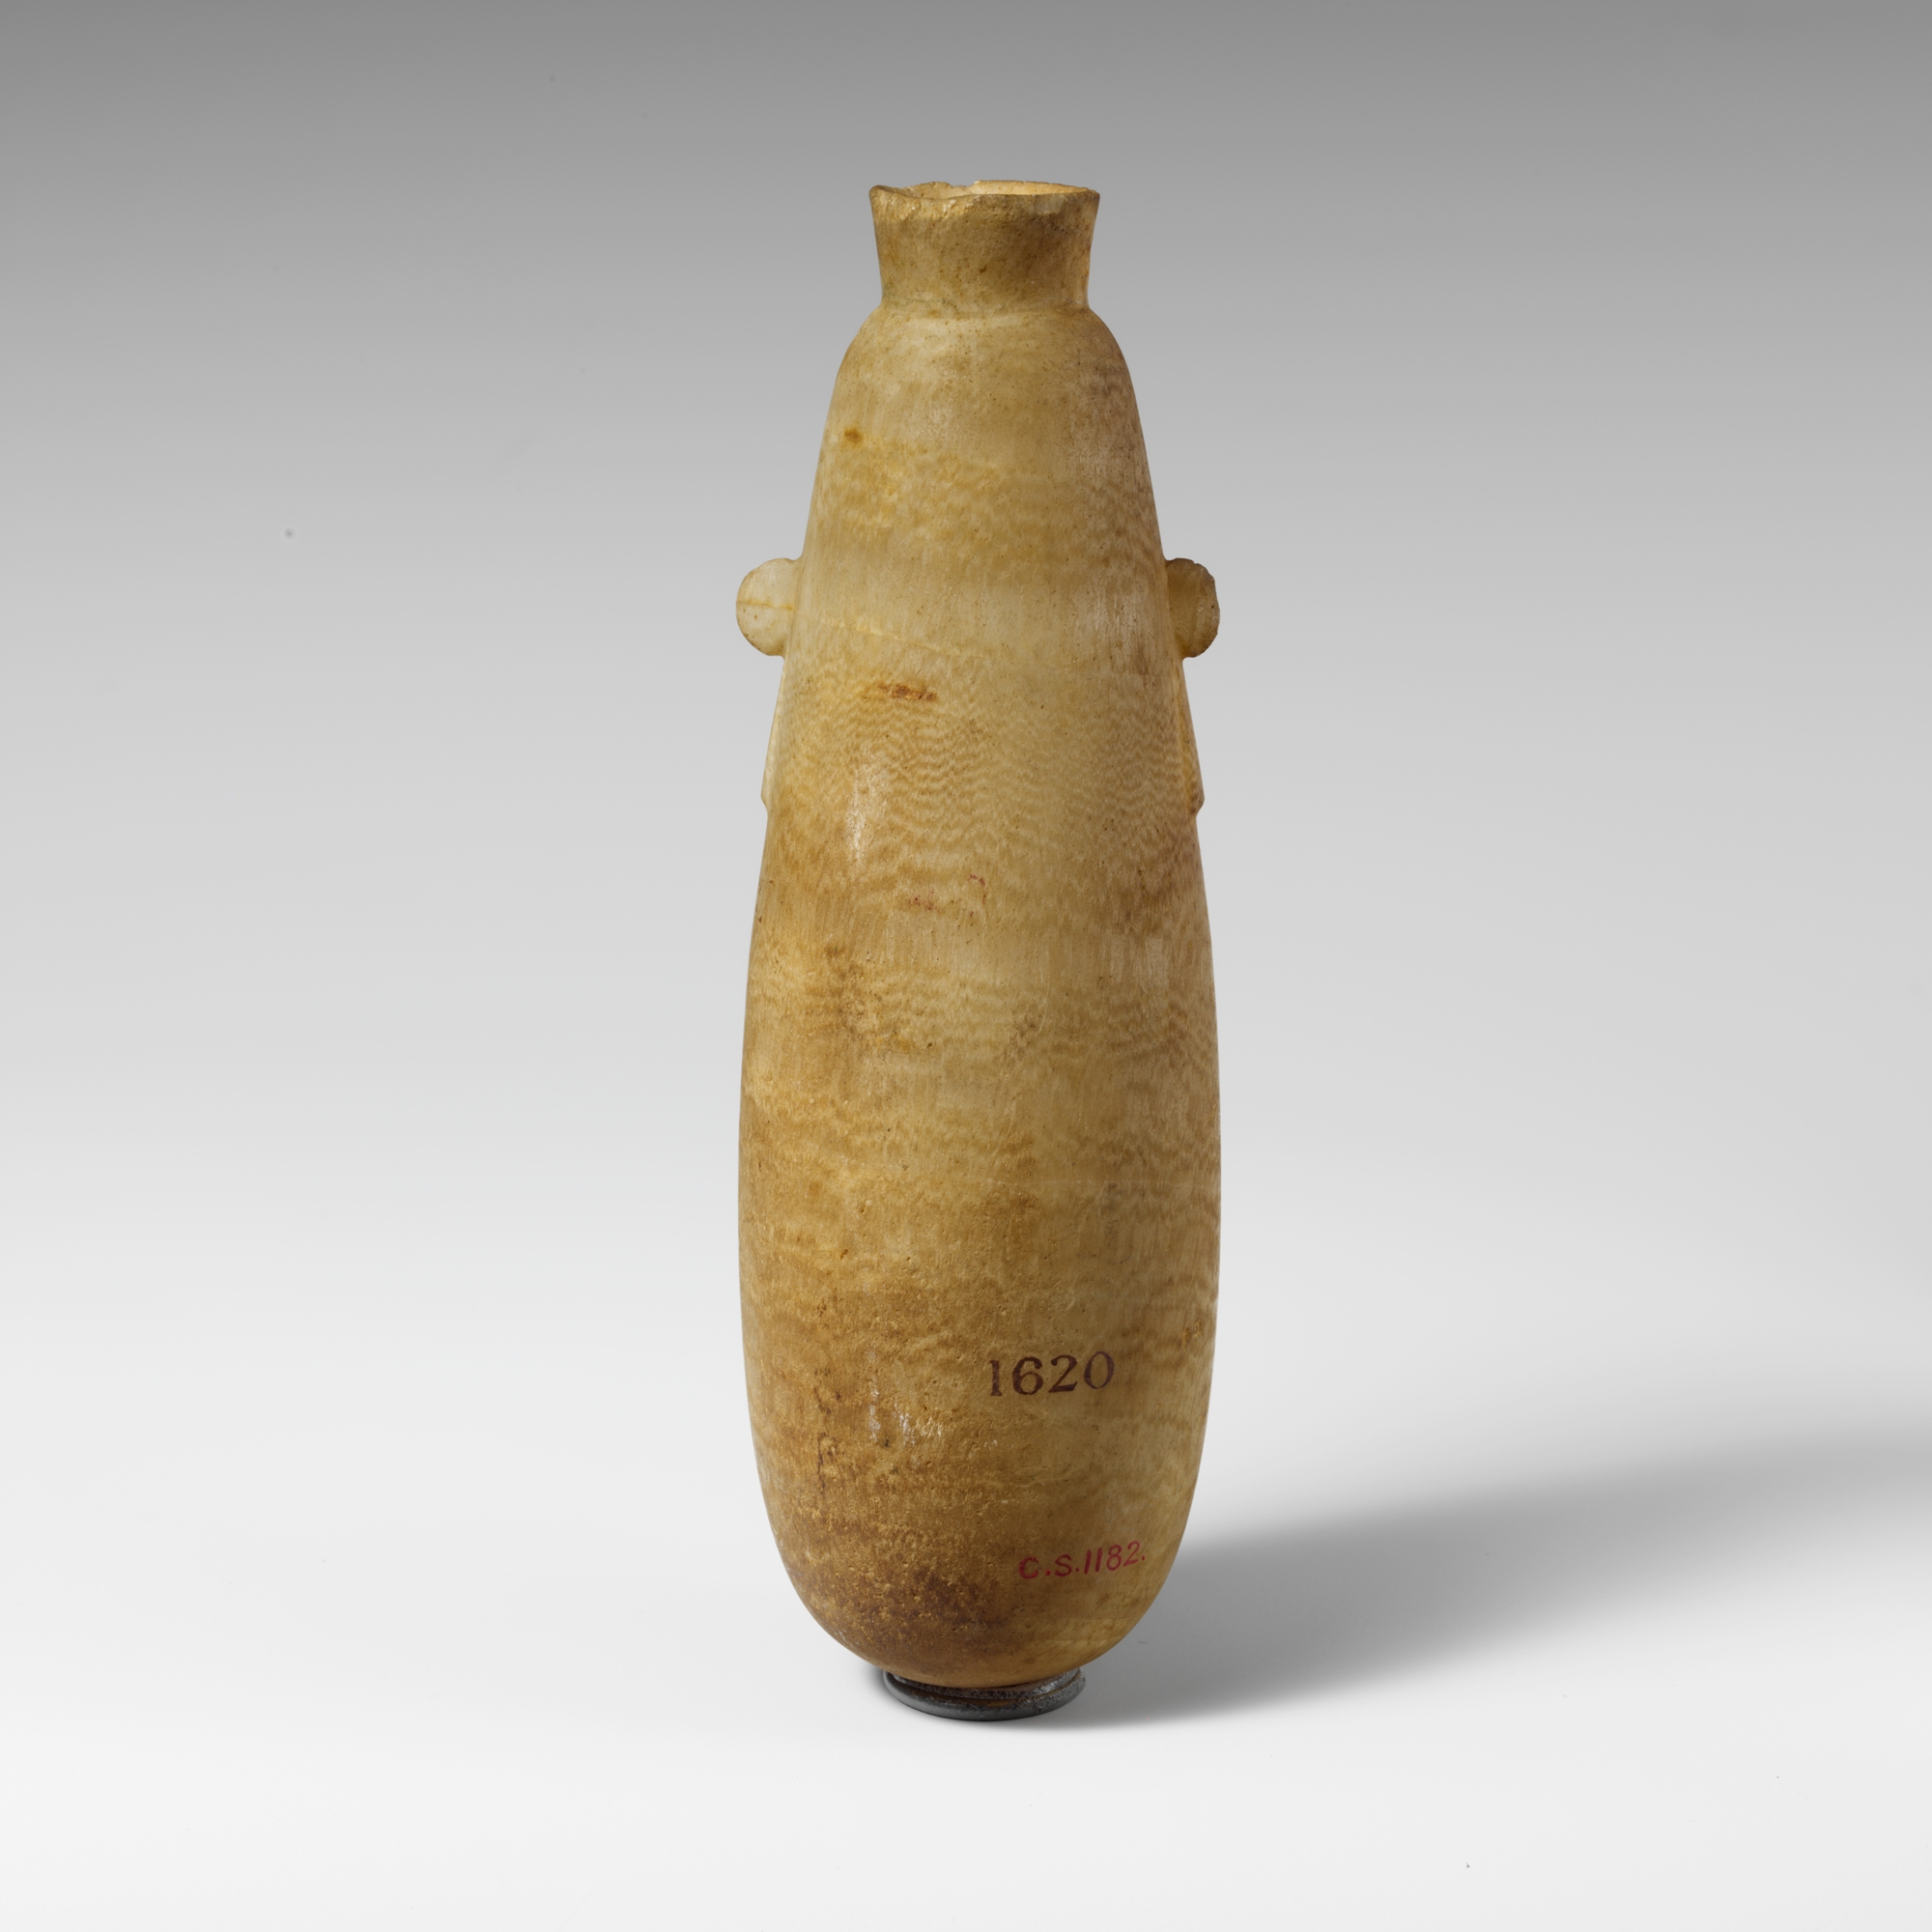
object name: alabastron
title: Alabaster alabastron (perfume vase)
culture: cypriot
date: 500-301 BCE